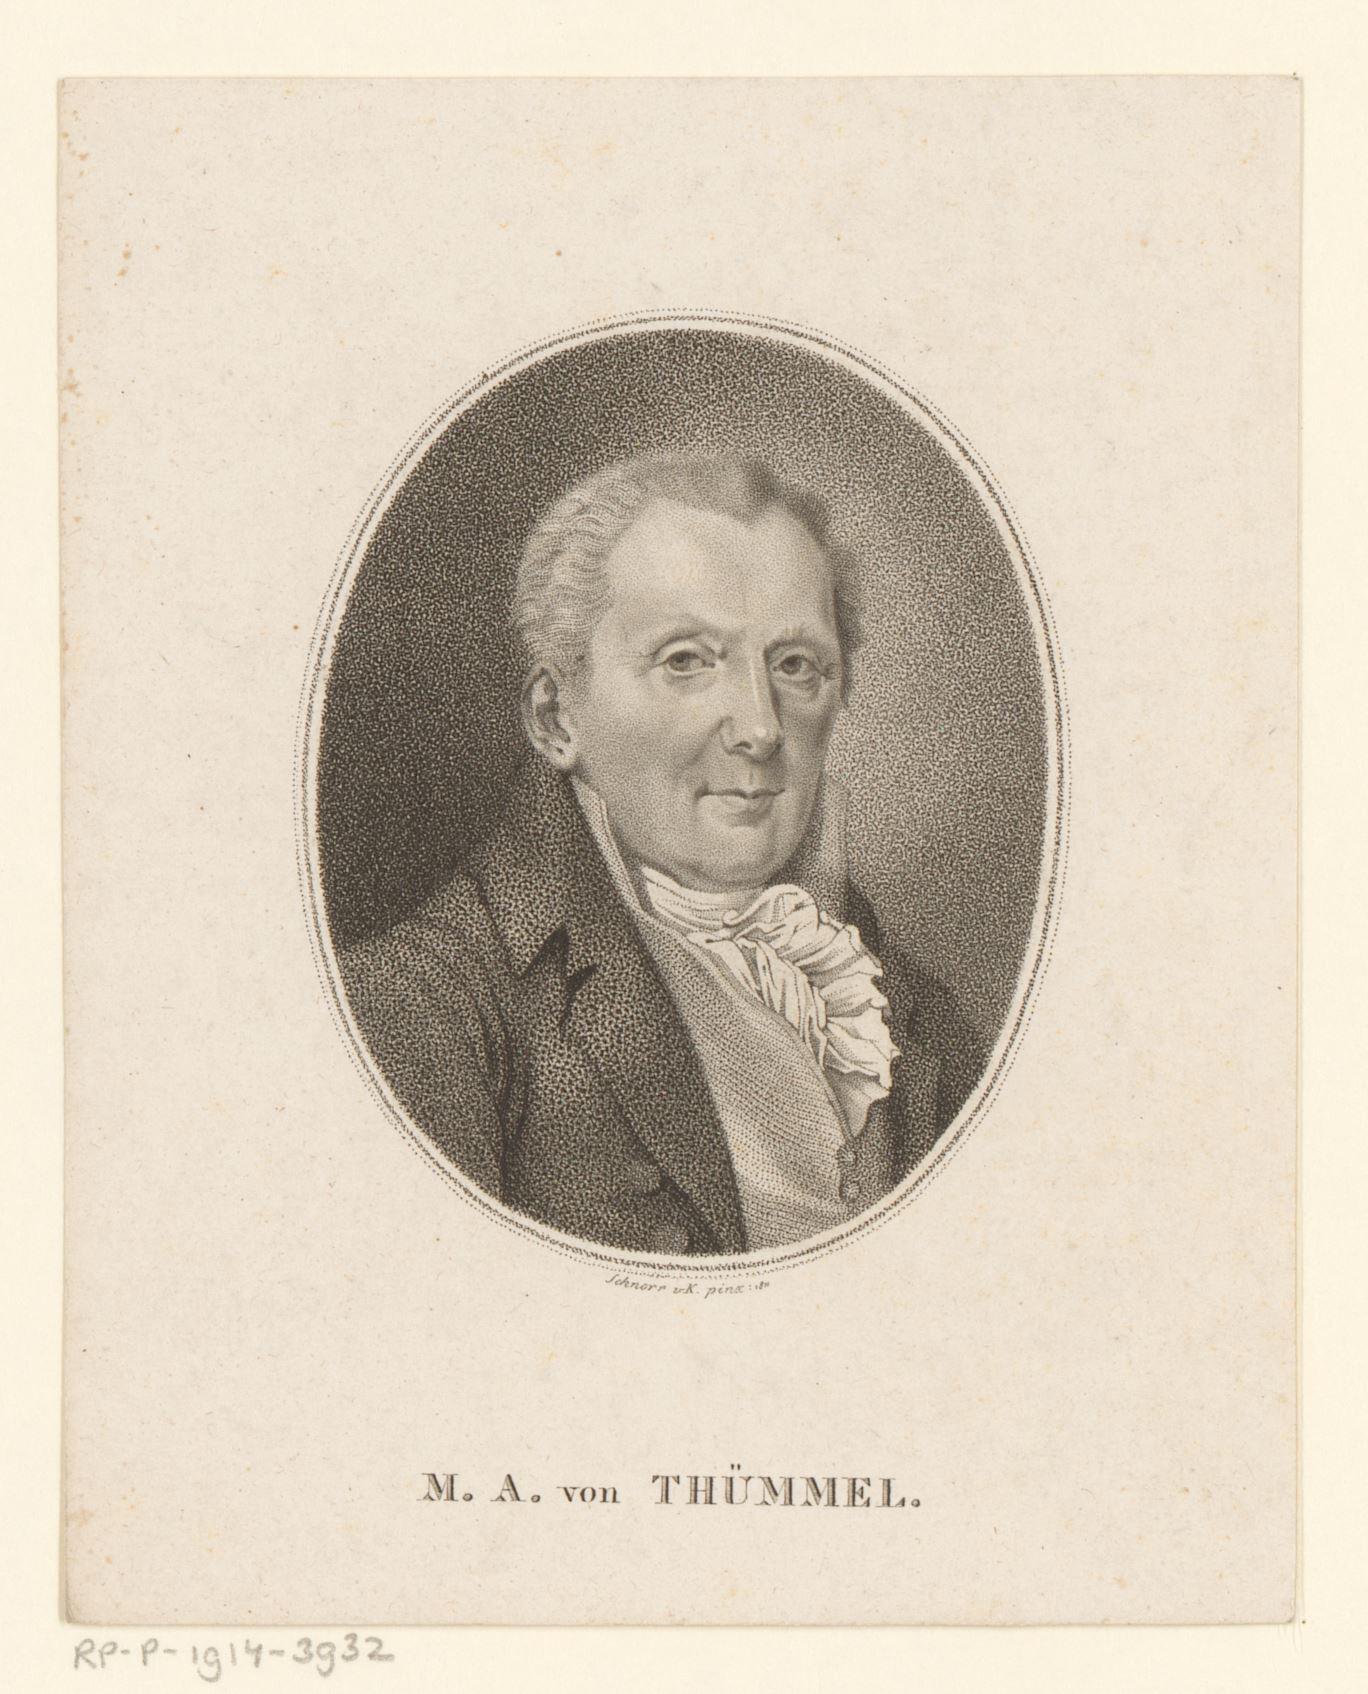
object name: print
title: Portret van Moritz August von Thümmel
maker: schnorr von carolsfeld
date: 1811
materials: paper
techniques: stippling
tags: historical persons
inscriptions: collector's mark: Lugt 2228